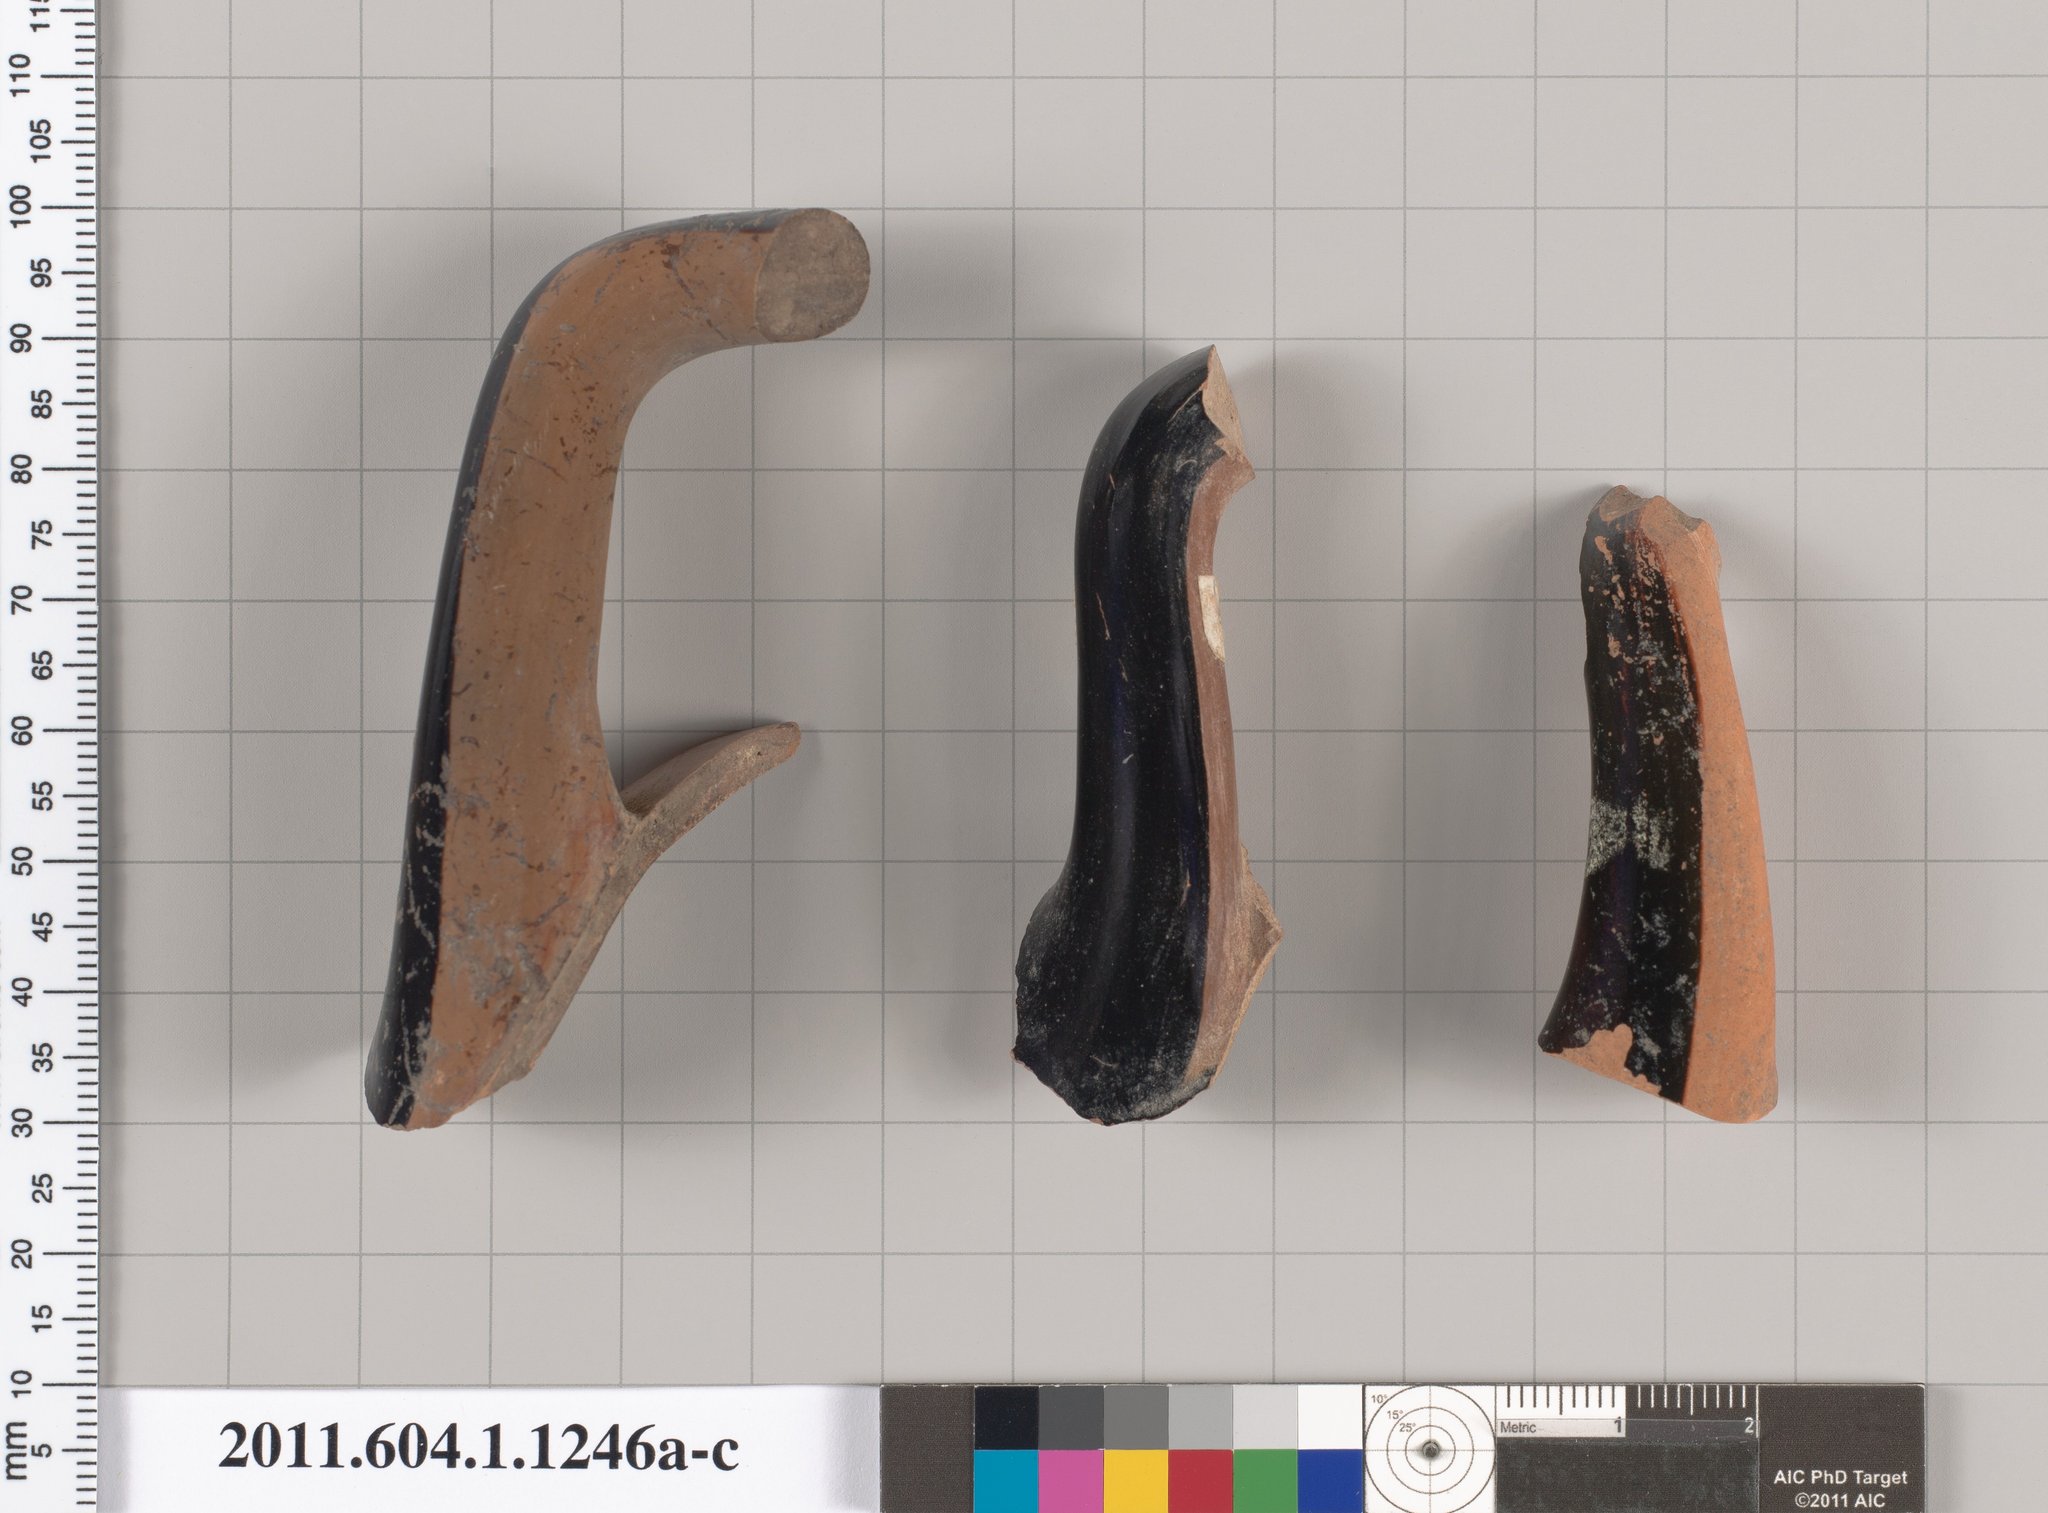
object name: kylix fragment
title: Terracotta fragments of kylikes (drinking cups)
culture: greek, attic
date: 500-401 BCE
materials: terracotta